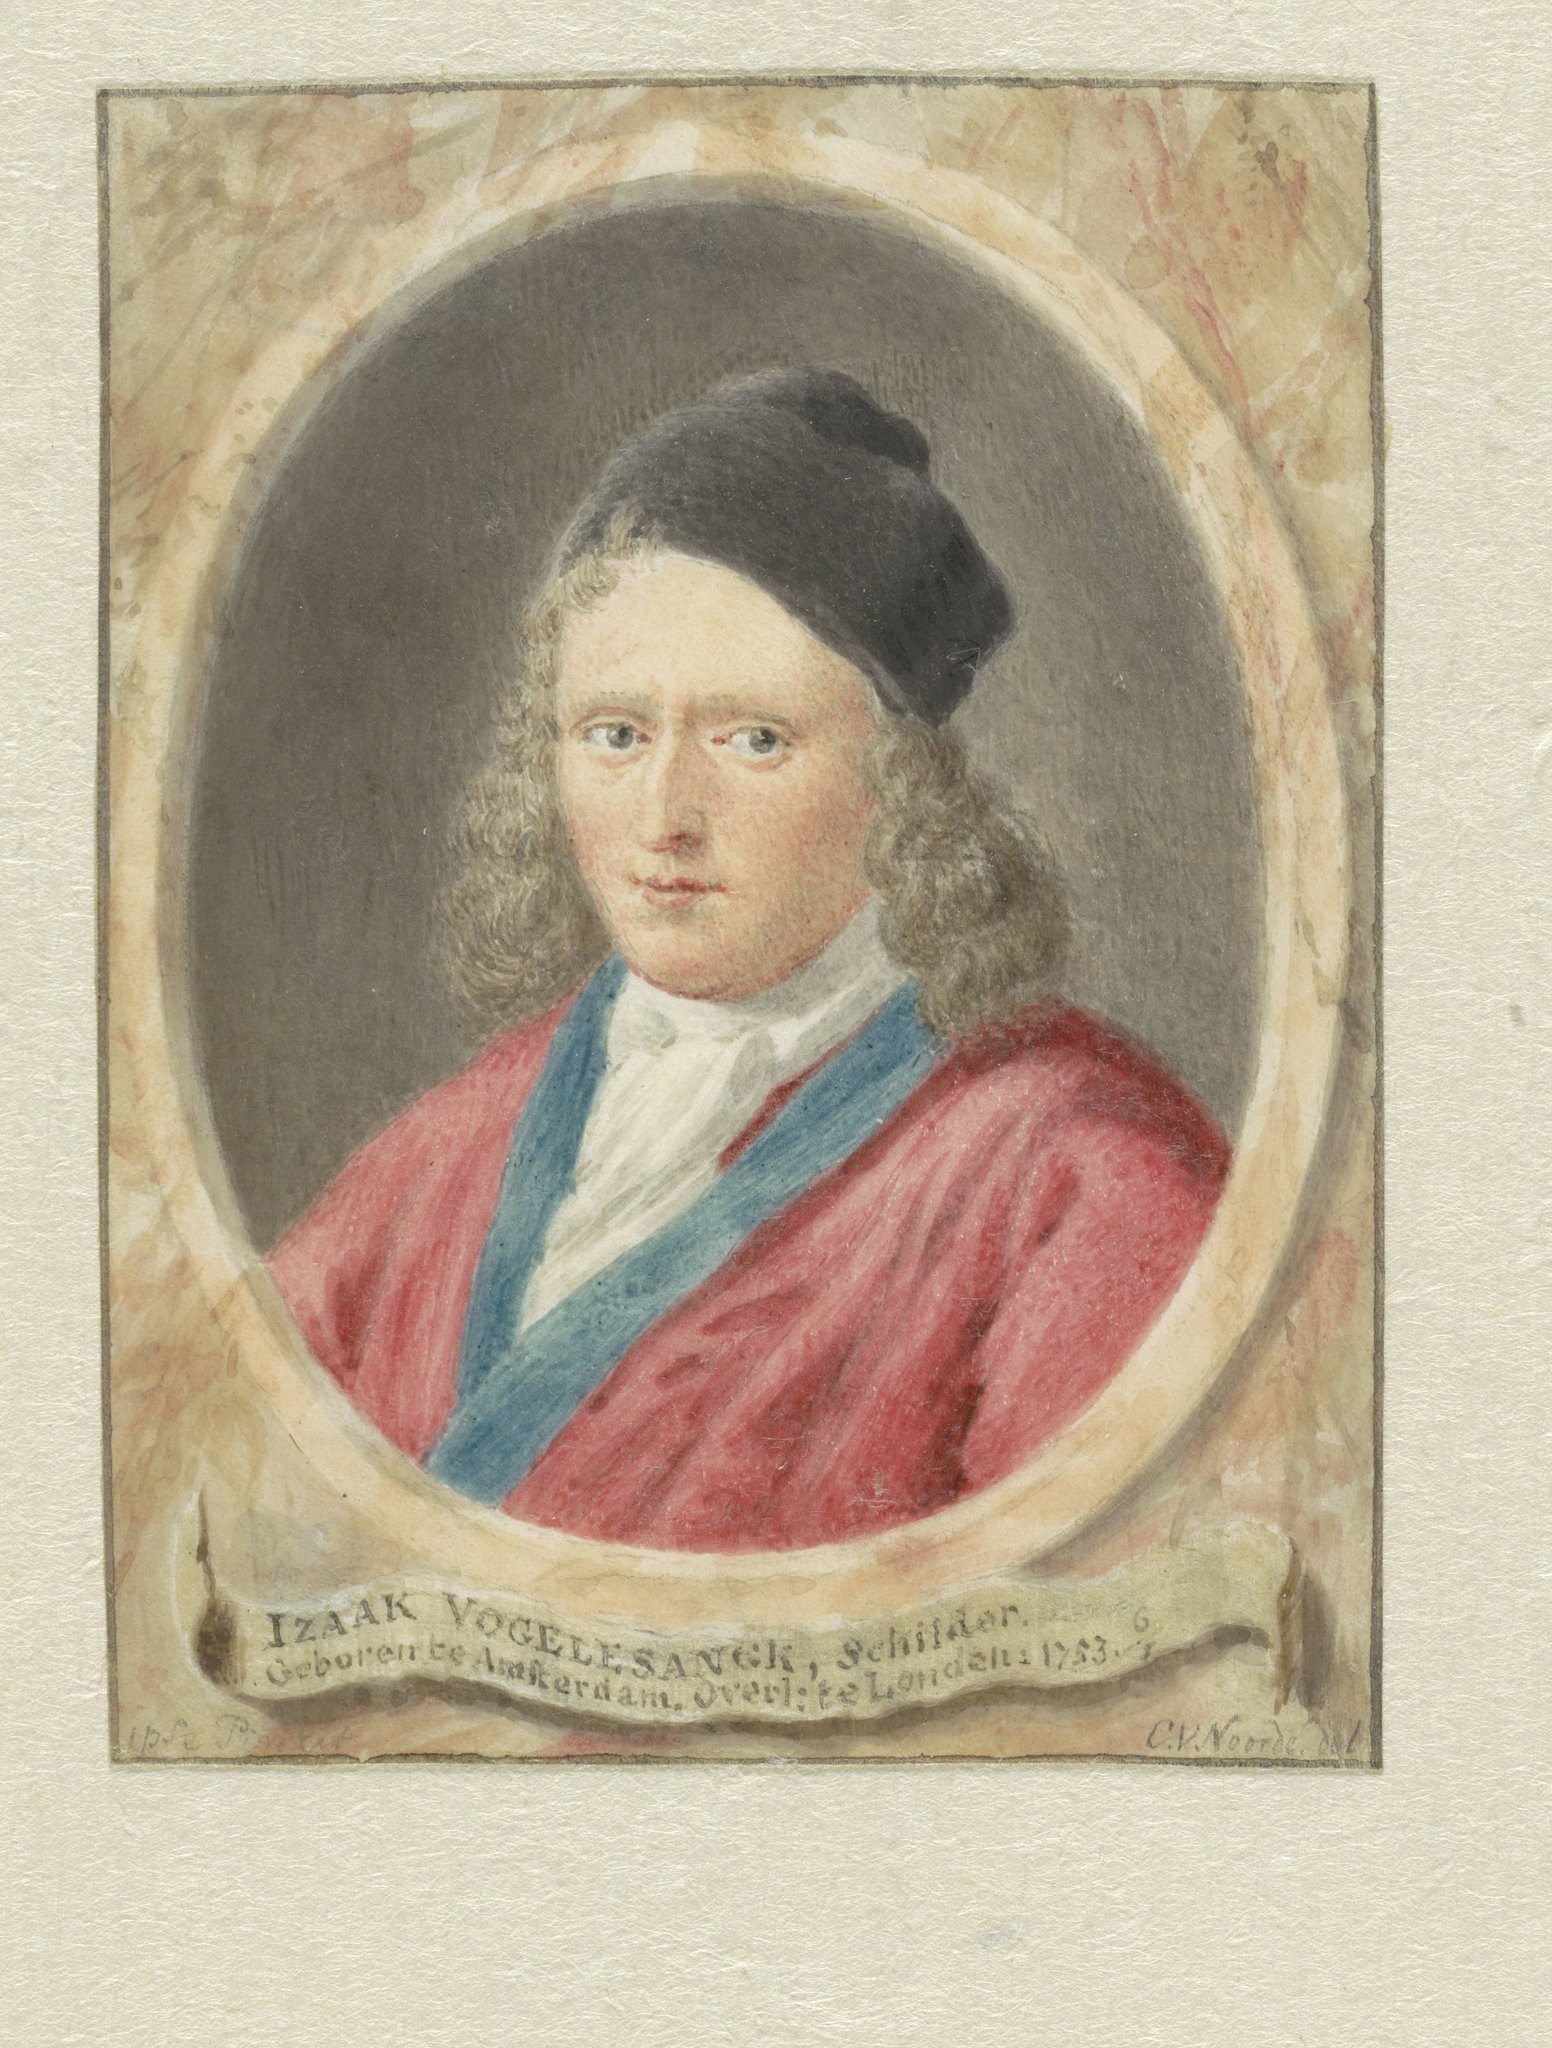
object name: drawing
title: Portrait of Isaac Vogelsang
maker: cornelis van noorde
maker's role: draughtsman, print maker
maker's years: 1731-1795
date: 1741-1795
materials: paint, parchment, pencil, watercolor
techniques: brush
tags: amsterdam, london, painter, izaak vogelensanck, historical persons, portrait, self-portrait of painter, portrait, self-portrait of artist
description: The baker’s son Cornelis van Noorde was trained as a portraitist. He was a key figure in the Haarlem art world and immortalized many colleagues, including the painter Isaac Vogelsang. Vogelsang’s career did not get off the ground in the Netherlands and he therefore tried his luck in England at an early age, for which he was harshly criticized. He died in London in 1753. Van Noorde made this portrait of him shortly thereafter.